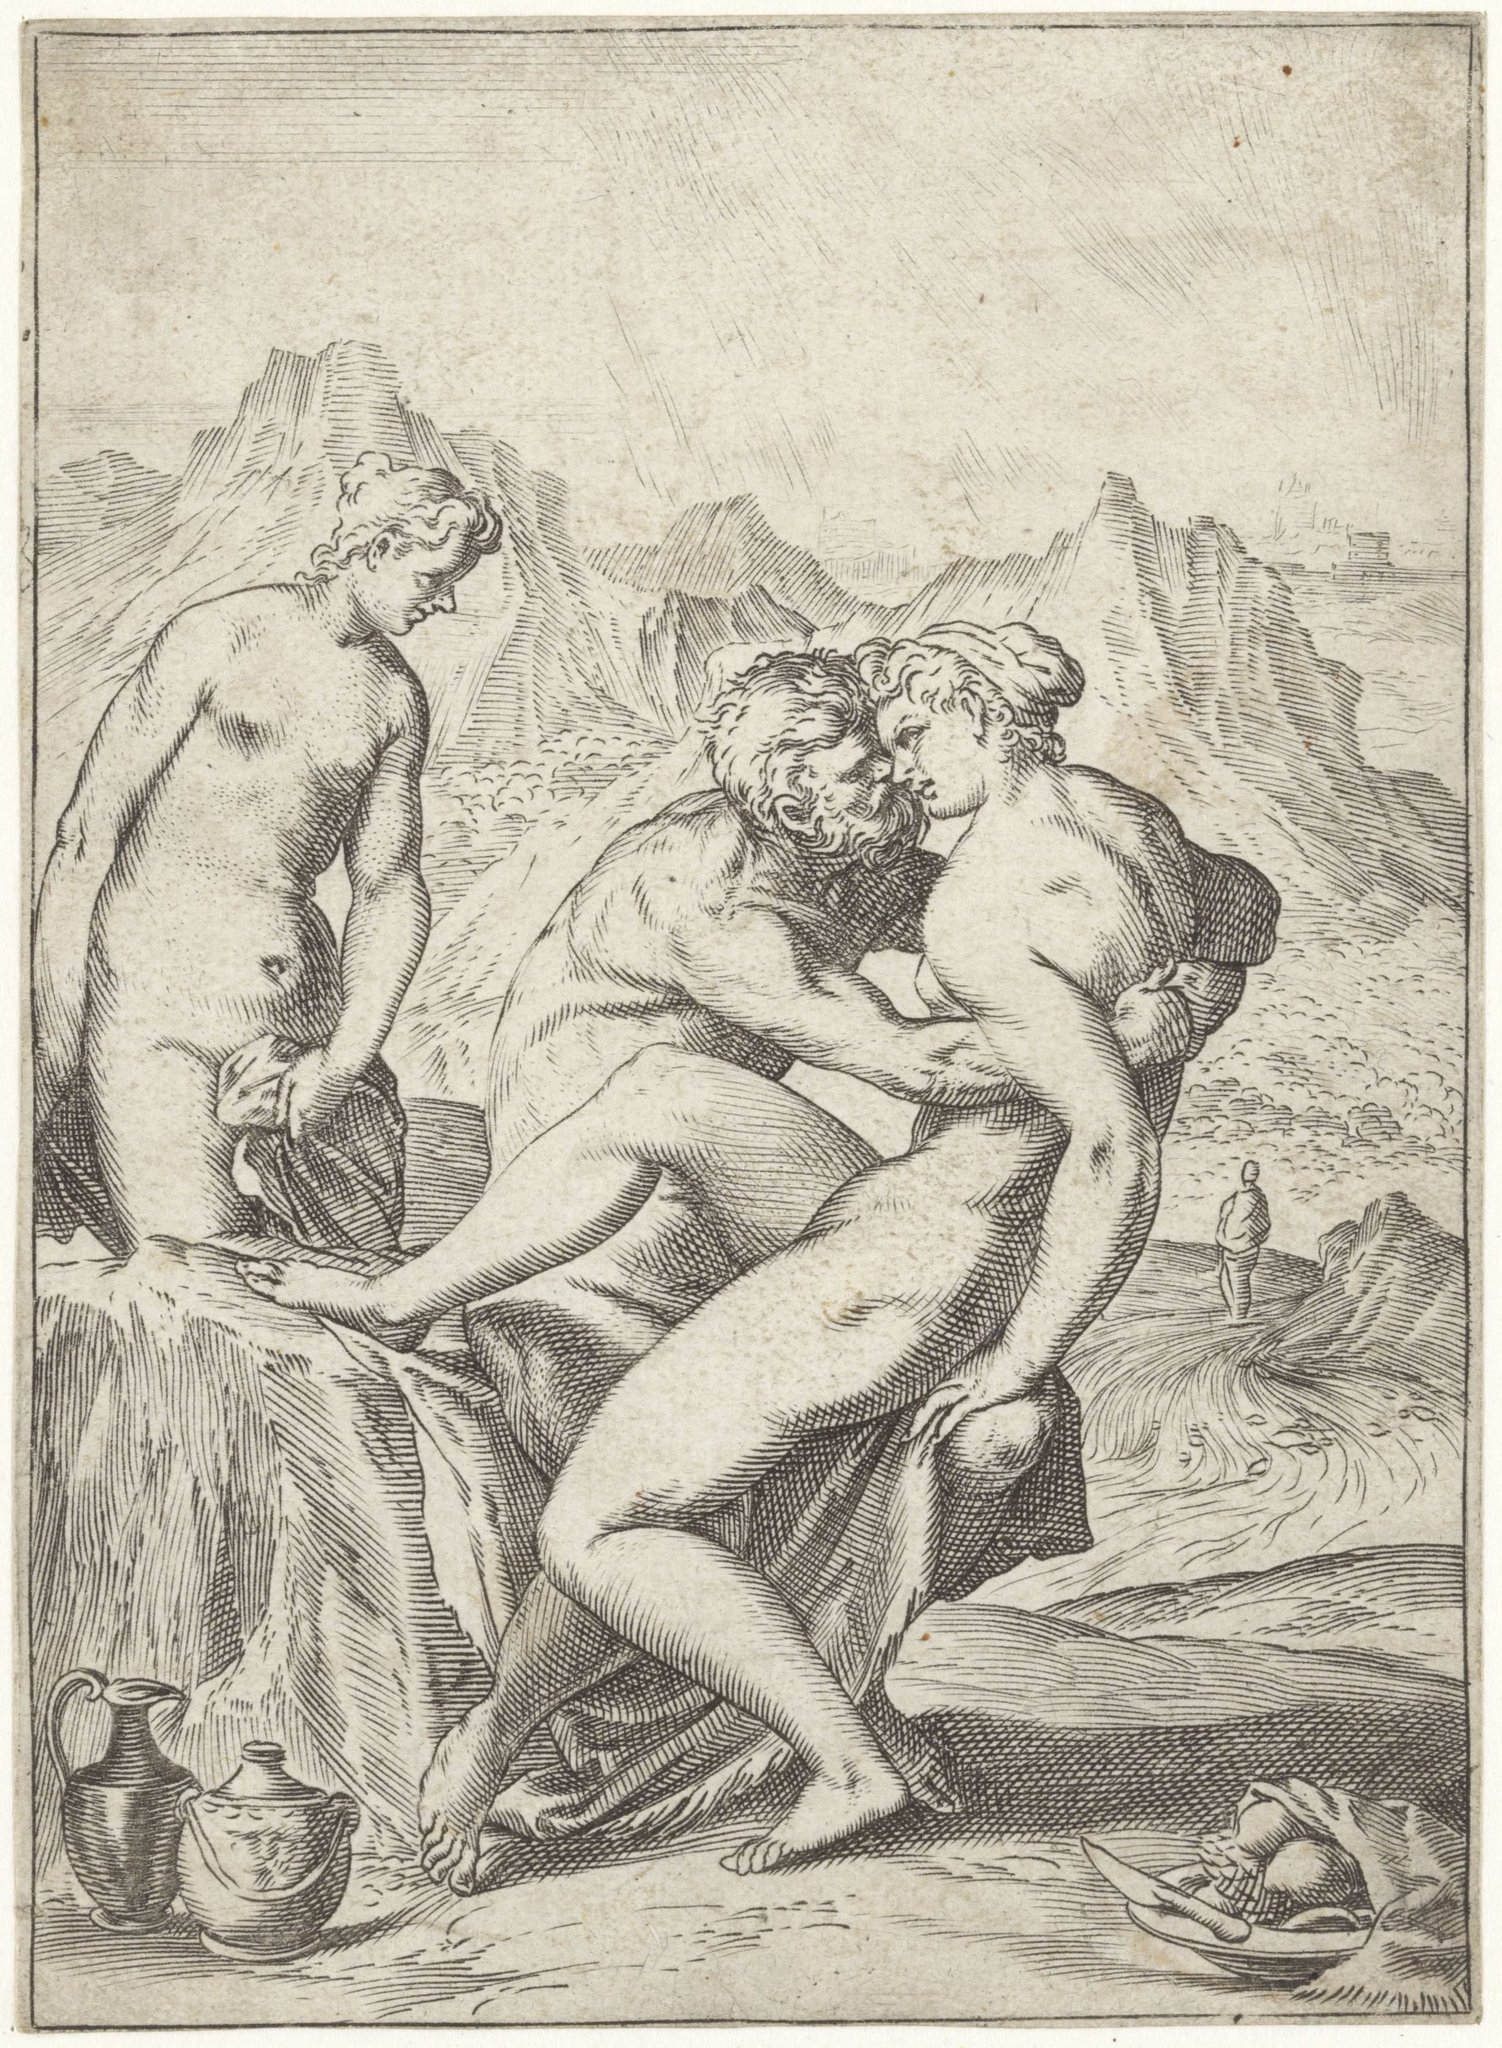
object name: print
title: Lot en zijn dochters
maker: agostino carracci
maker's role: draughtsman, painter, print maker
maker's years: 1557-1602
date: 1590-1595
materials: paper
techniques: engraving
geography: italy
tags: lot and his daughters (genesis 19:30-38)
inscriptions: collector's mark: Lugt 240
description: Lot zittend op een rots. Zijn twee dochters voeren hem dronken en verleiden hem.